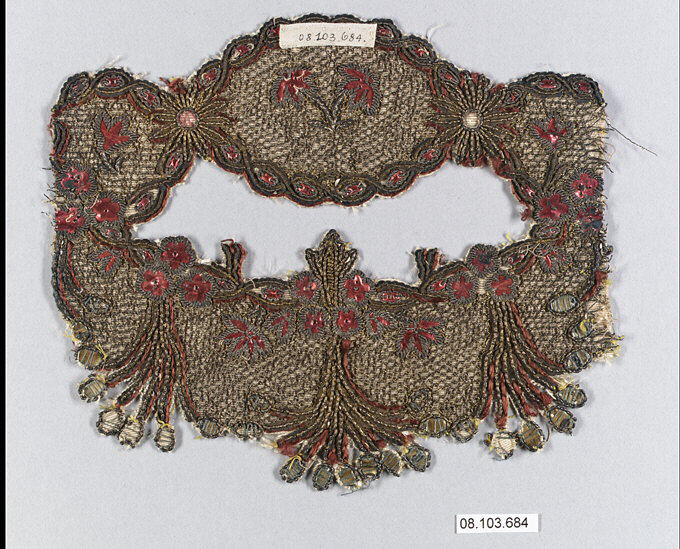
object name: passementerie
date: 1801-1900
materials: metal